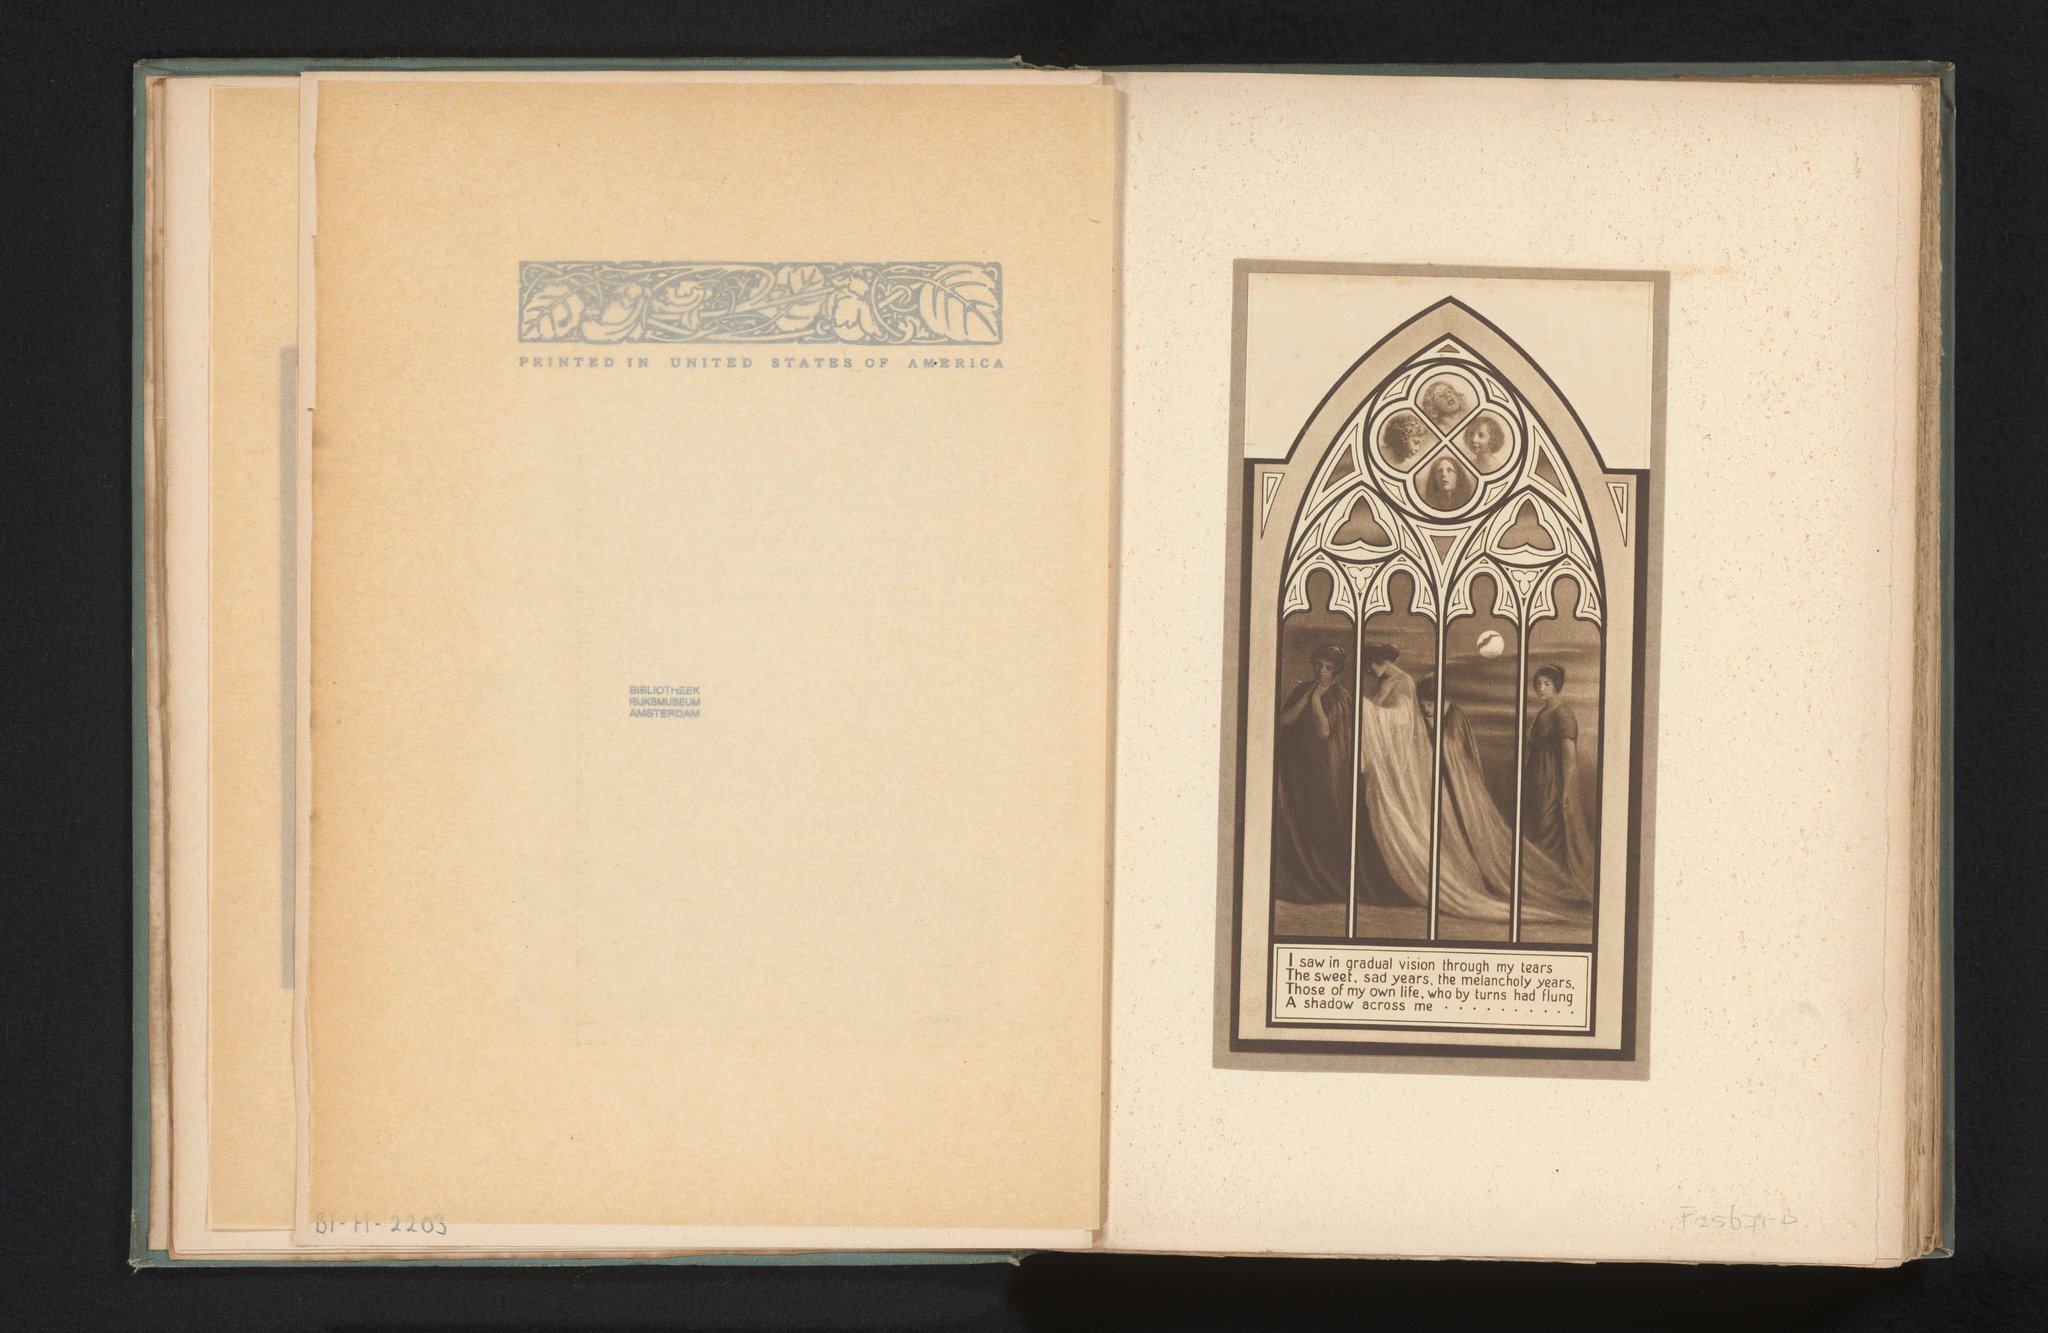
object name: page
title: Vier vrouwen achter een kerkraam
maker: adelaide hanscom leeson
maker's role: painter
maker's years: 1875-1931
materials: cardboard, paper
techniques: photoaquatint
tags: lyre, cithara, psaltery, child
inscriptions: copyright notice: ‘C’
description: Prent op ongenummerde pagina. Adelaide Hanscom Leeson manipuleerde haar glasnegatieven om een schilderachtig efffect te bewerkstelligen.